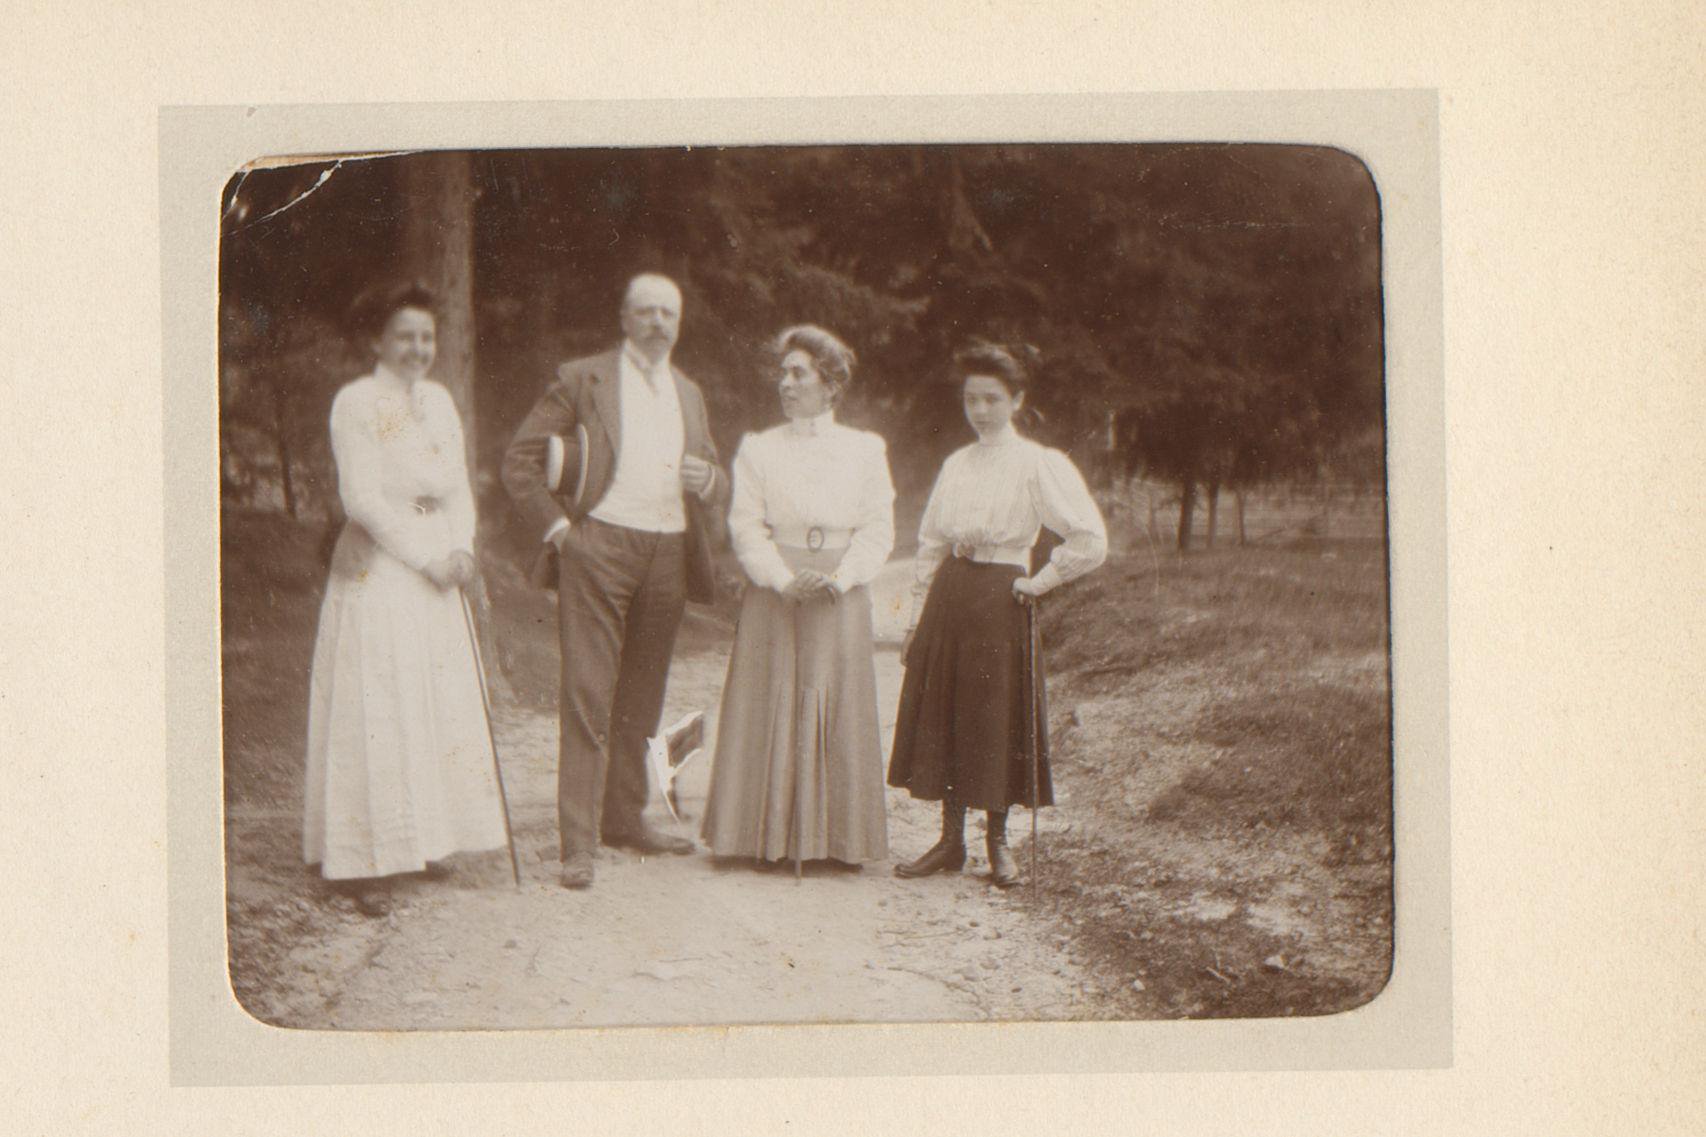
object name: photograph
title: Portret van twee vrouwen, een man en een meisje op een bospad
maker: liesbeth overhoff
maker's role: fotograaf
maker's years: 1895-1969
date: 1910-1915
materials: paper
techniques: collodion silver print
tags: forest path or lane, anonymous historical persons portrayed in a group, in a group-portrait